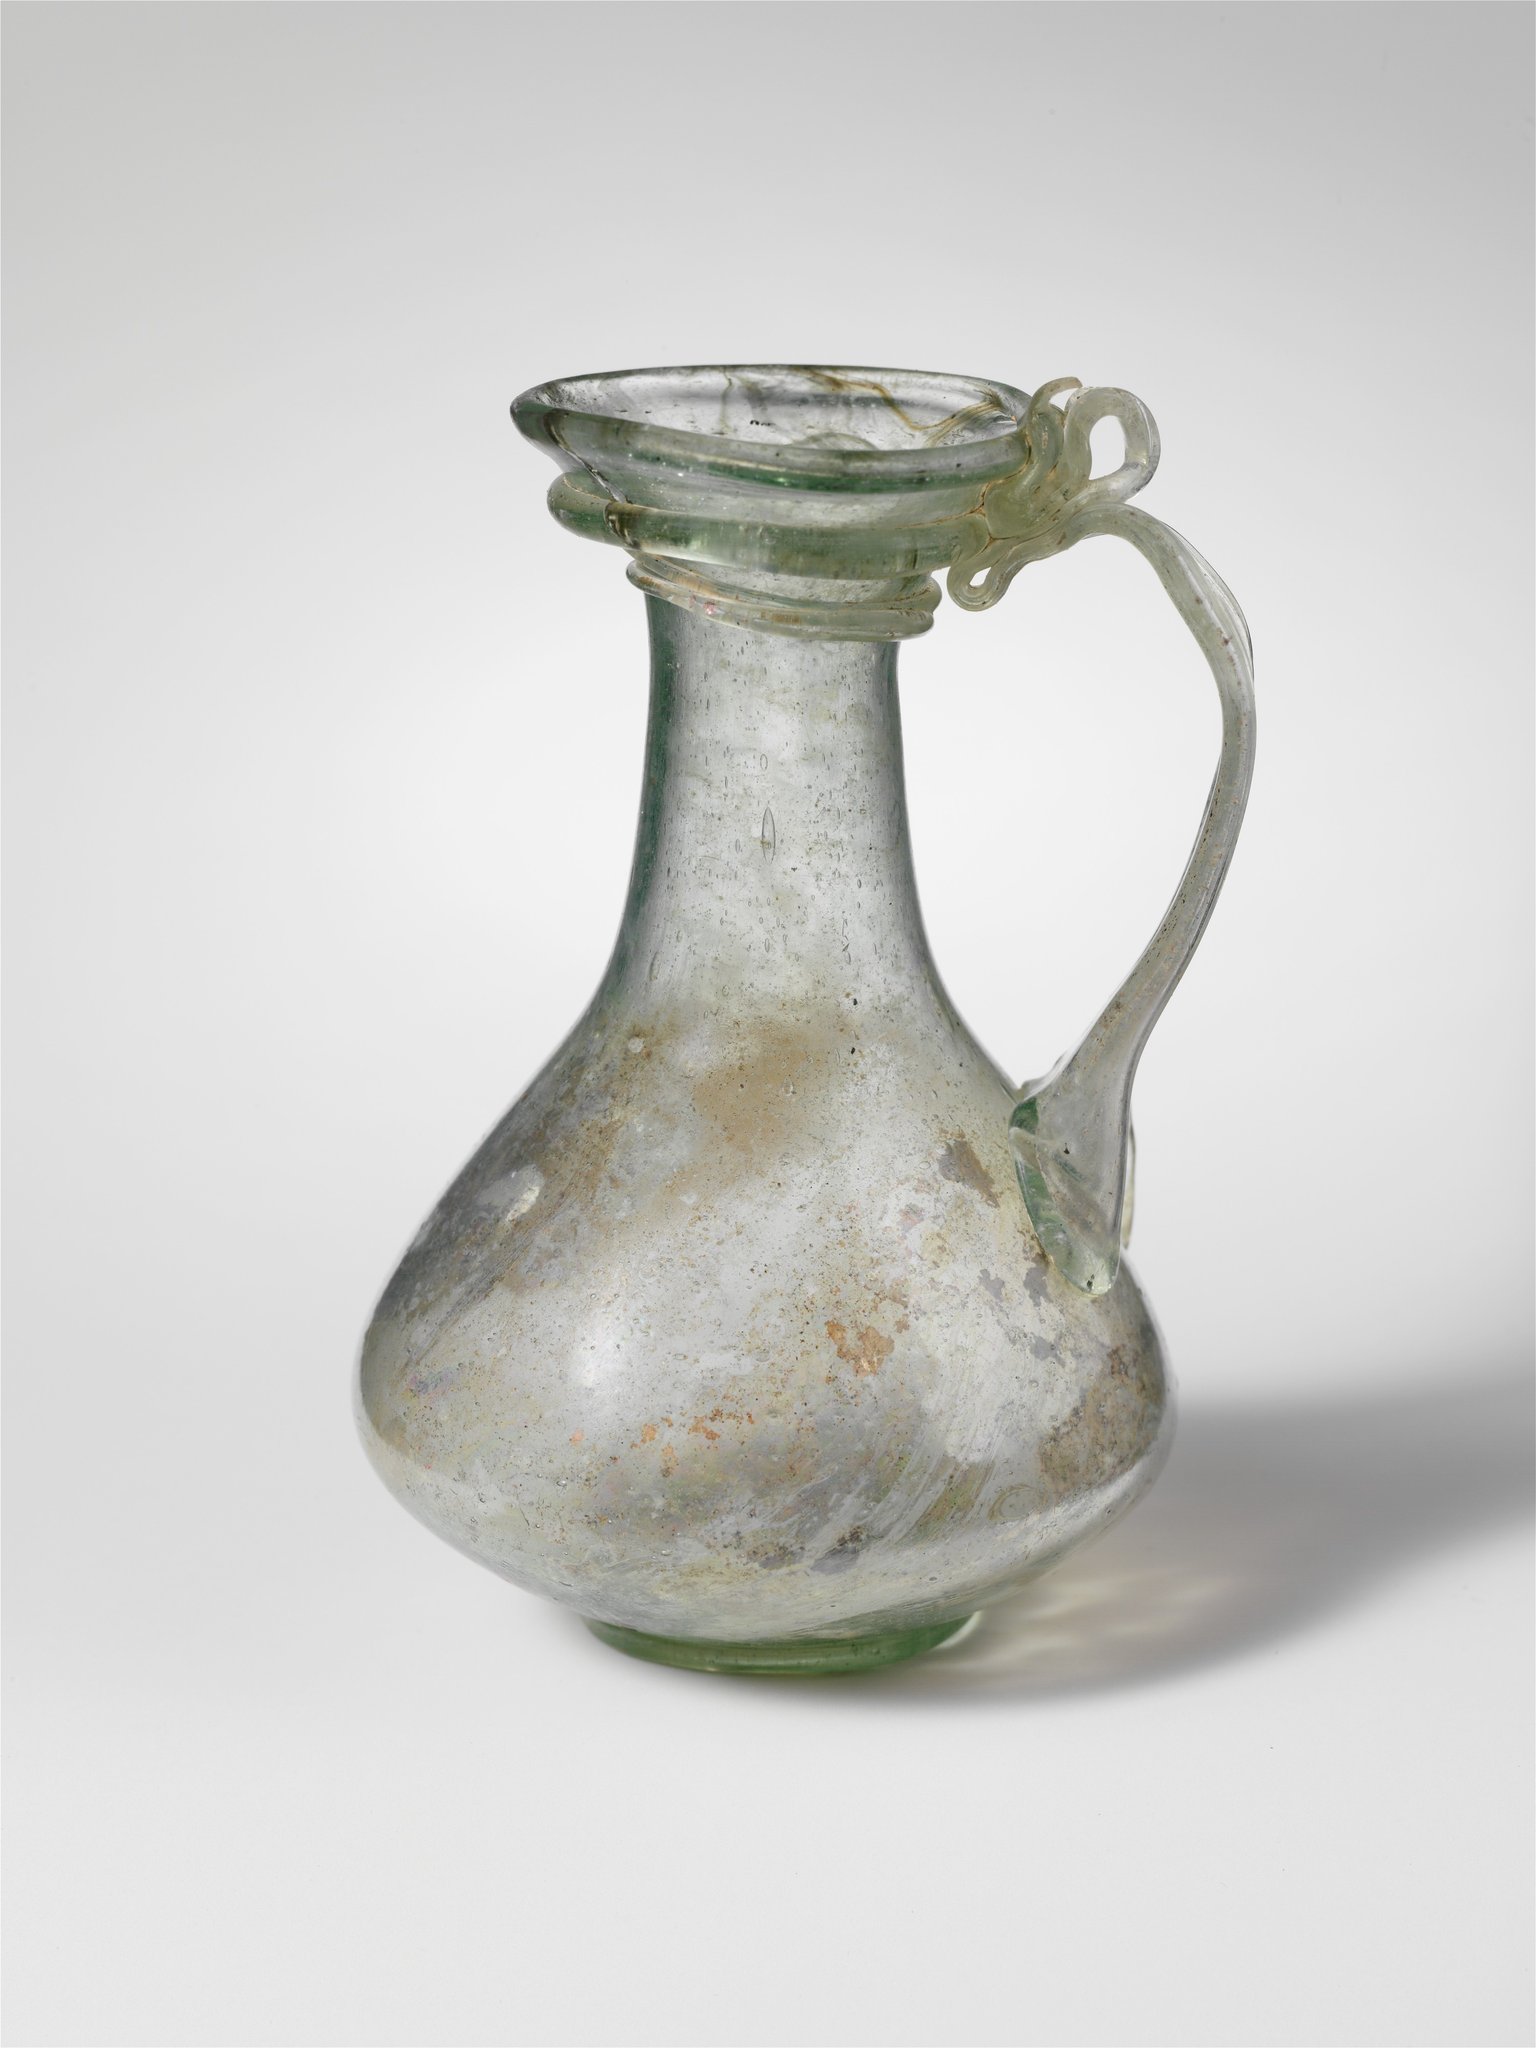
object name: jug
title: Glass jug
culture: roman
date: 201-400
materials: glass